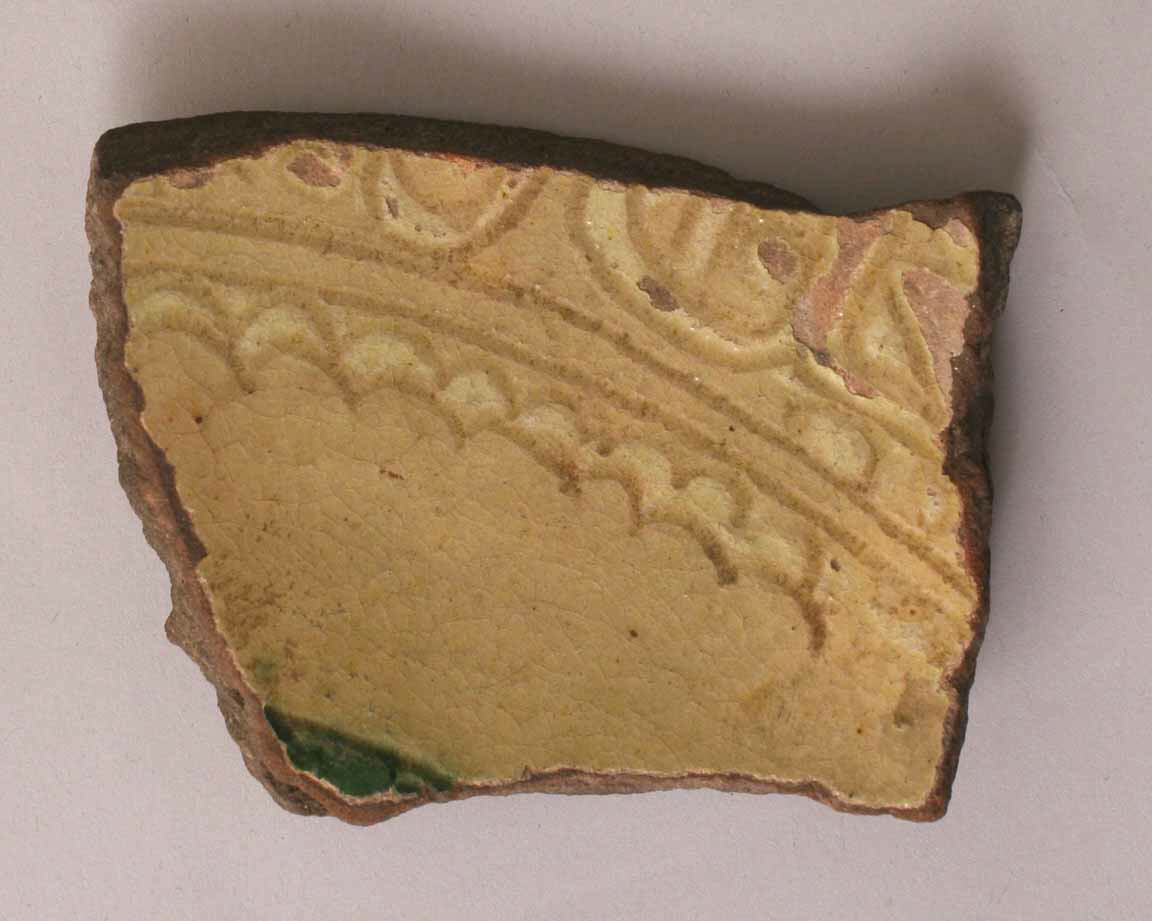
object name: ceramic fragment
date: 1301-1500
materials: earthenware, glaze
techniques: coloring, incising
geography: egypt